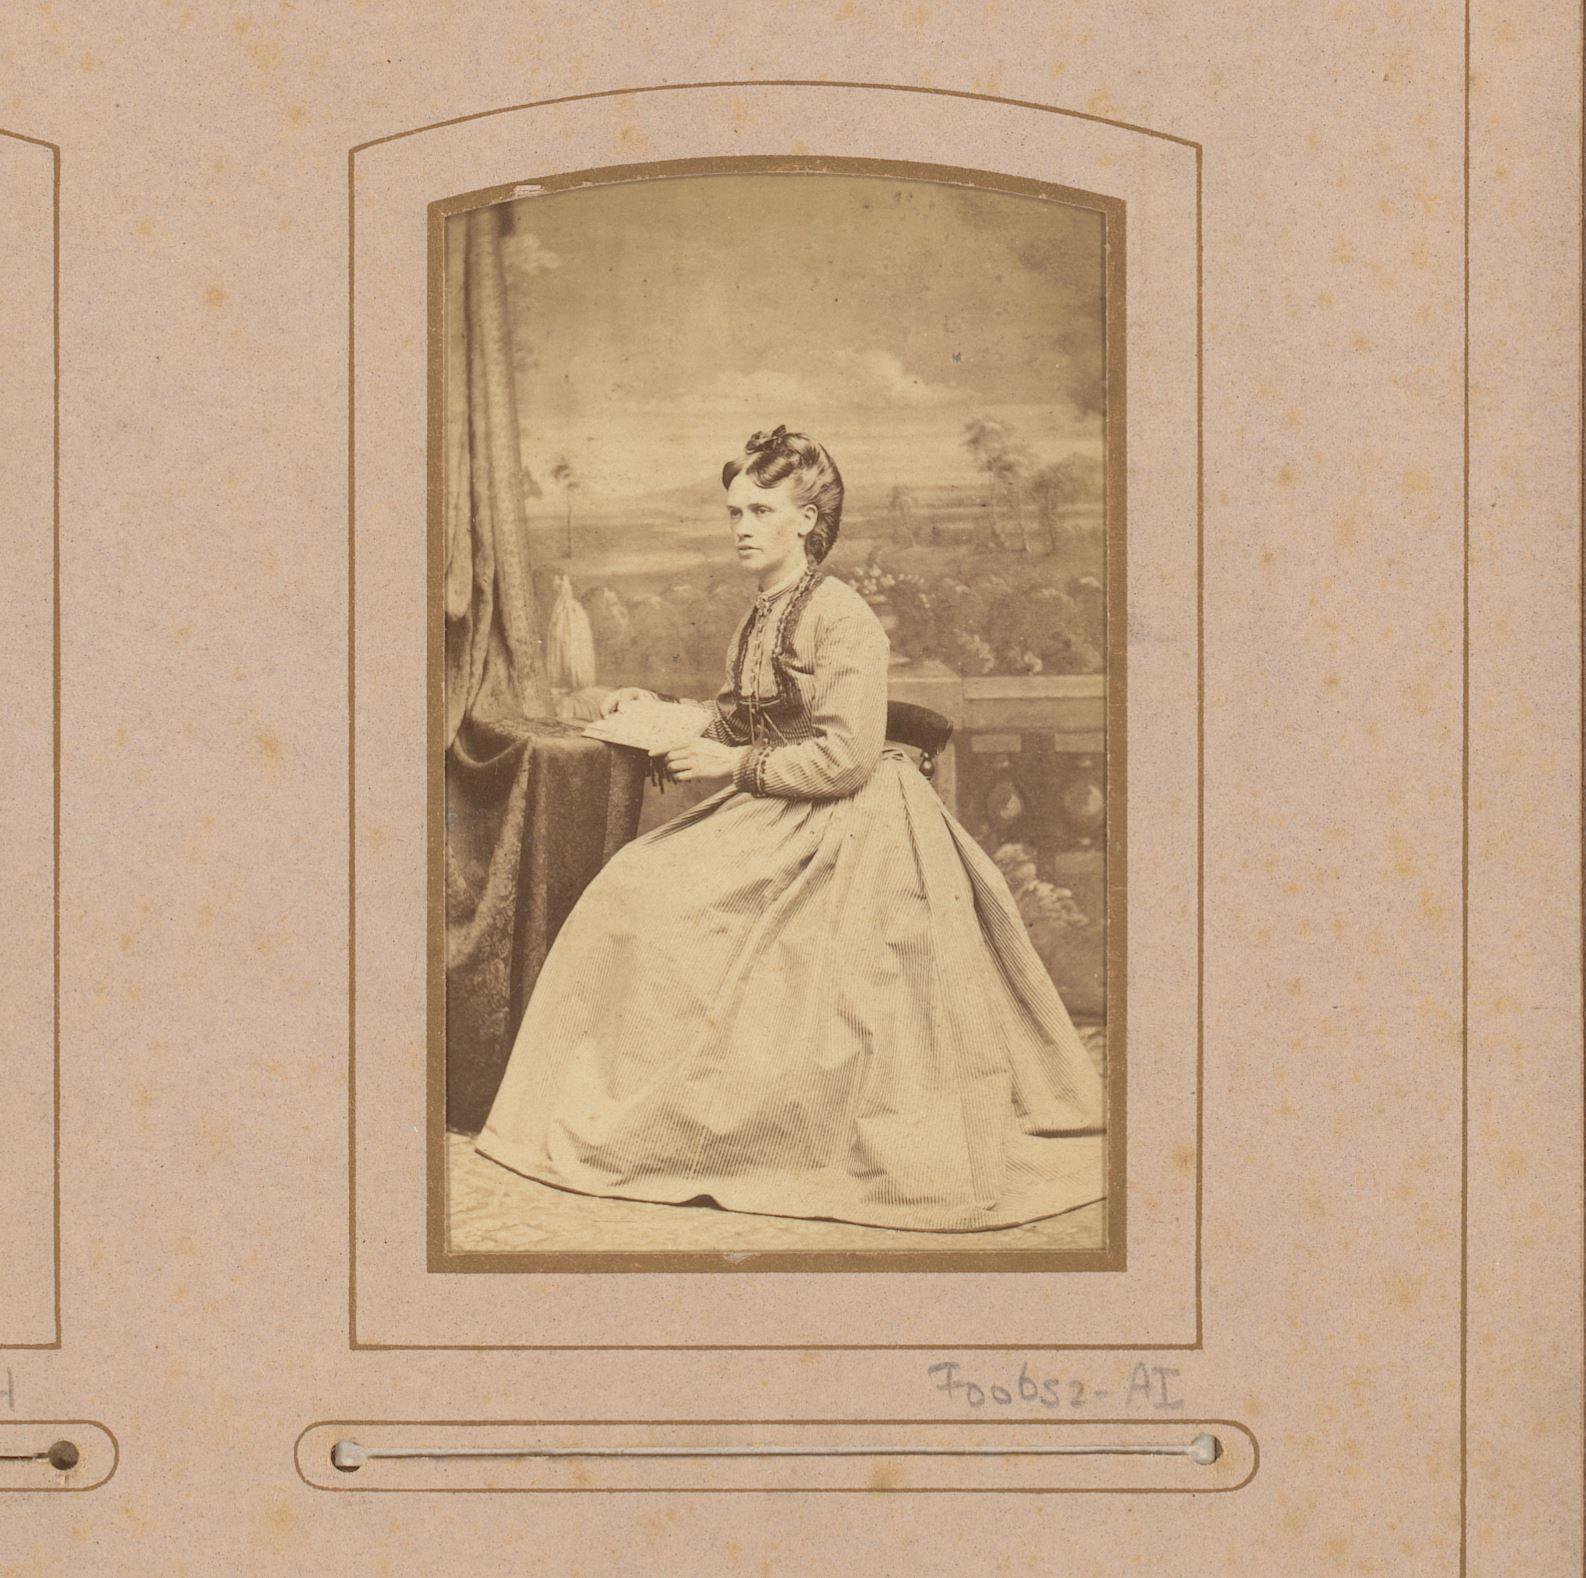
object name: photograph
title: Portret van een vrouw met boek in de hand, zittend aan een tafel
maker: c. könig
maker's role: fotograaf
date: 1870-1890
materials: cardboard, photographic support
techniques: albumen print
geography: london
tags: sitting figure - aa - female human figure, historical persons - bb - woman, table, book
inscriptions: inscription: ‘C. KŒNIC./ ARTIST & PHOTOGRAPHER/ 127, CHURCH St/ LATE I, NEW CHRUCH St/ EDCWARE ROAD N. W./ Copies may be had by sending/ this number No 5417’